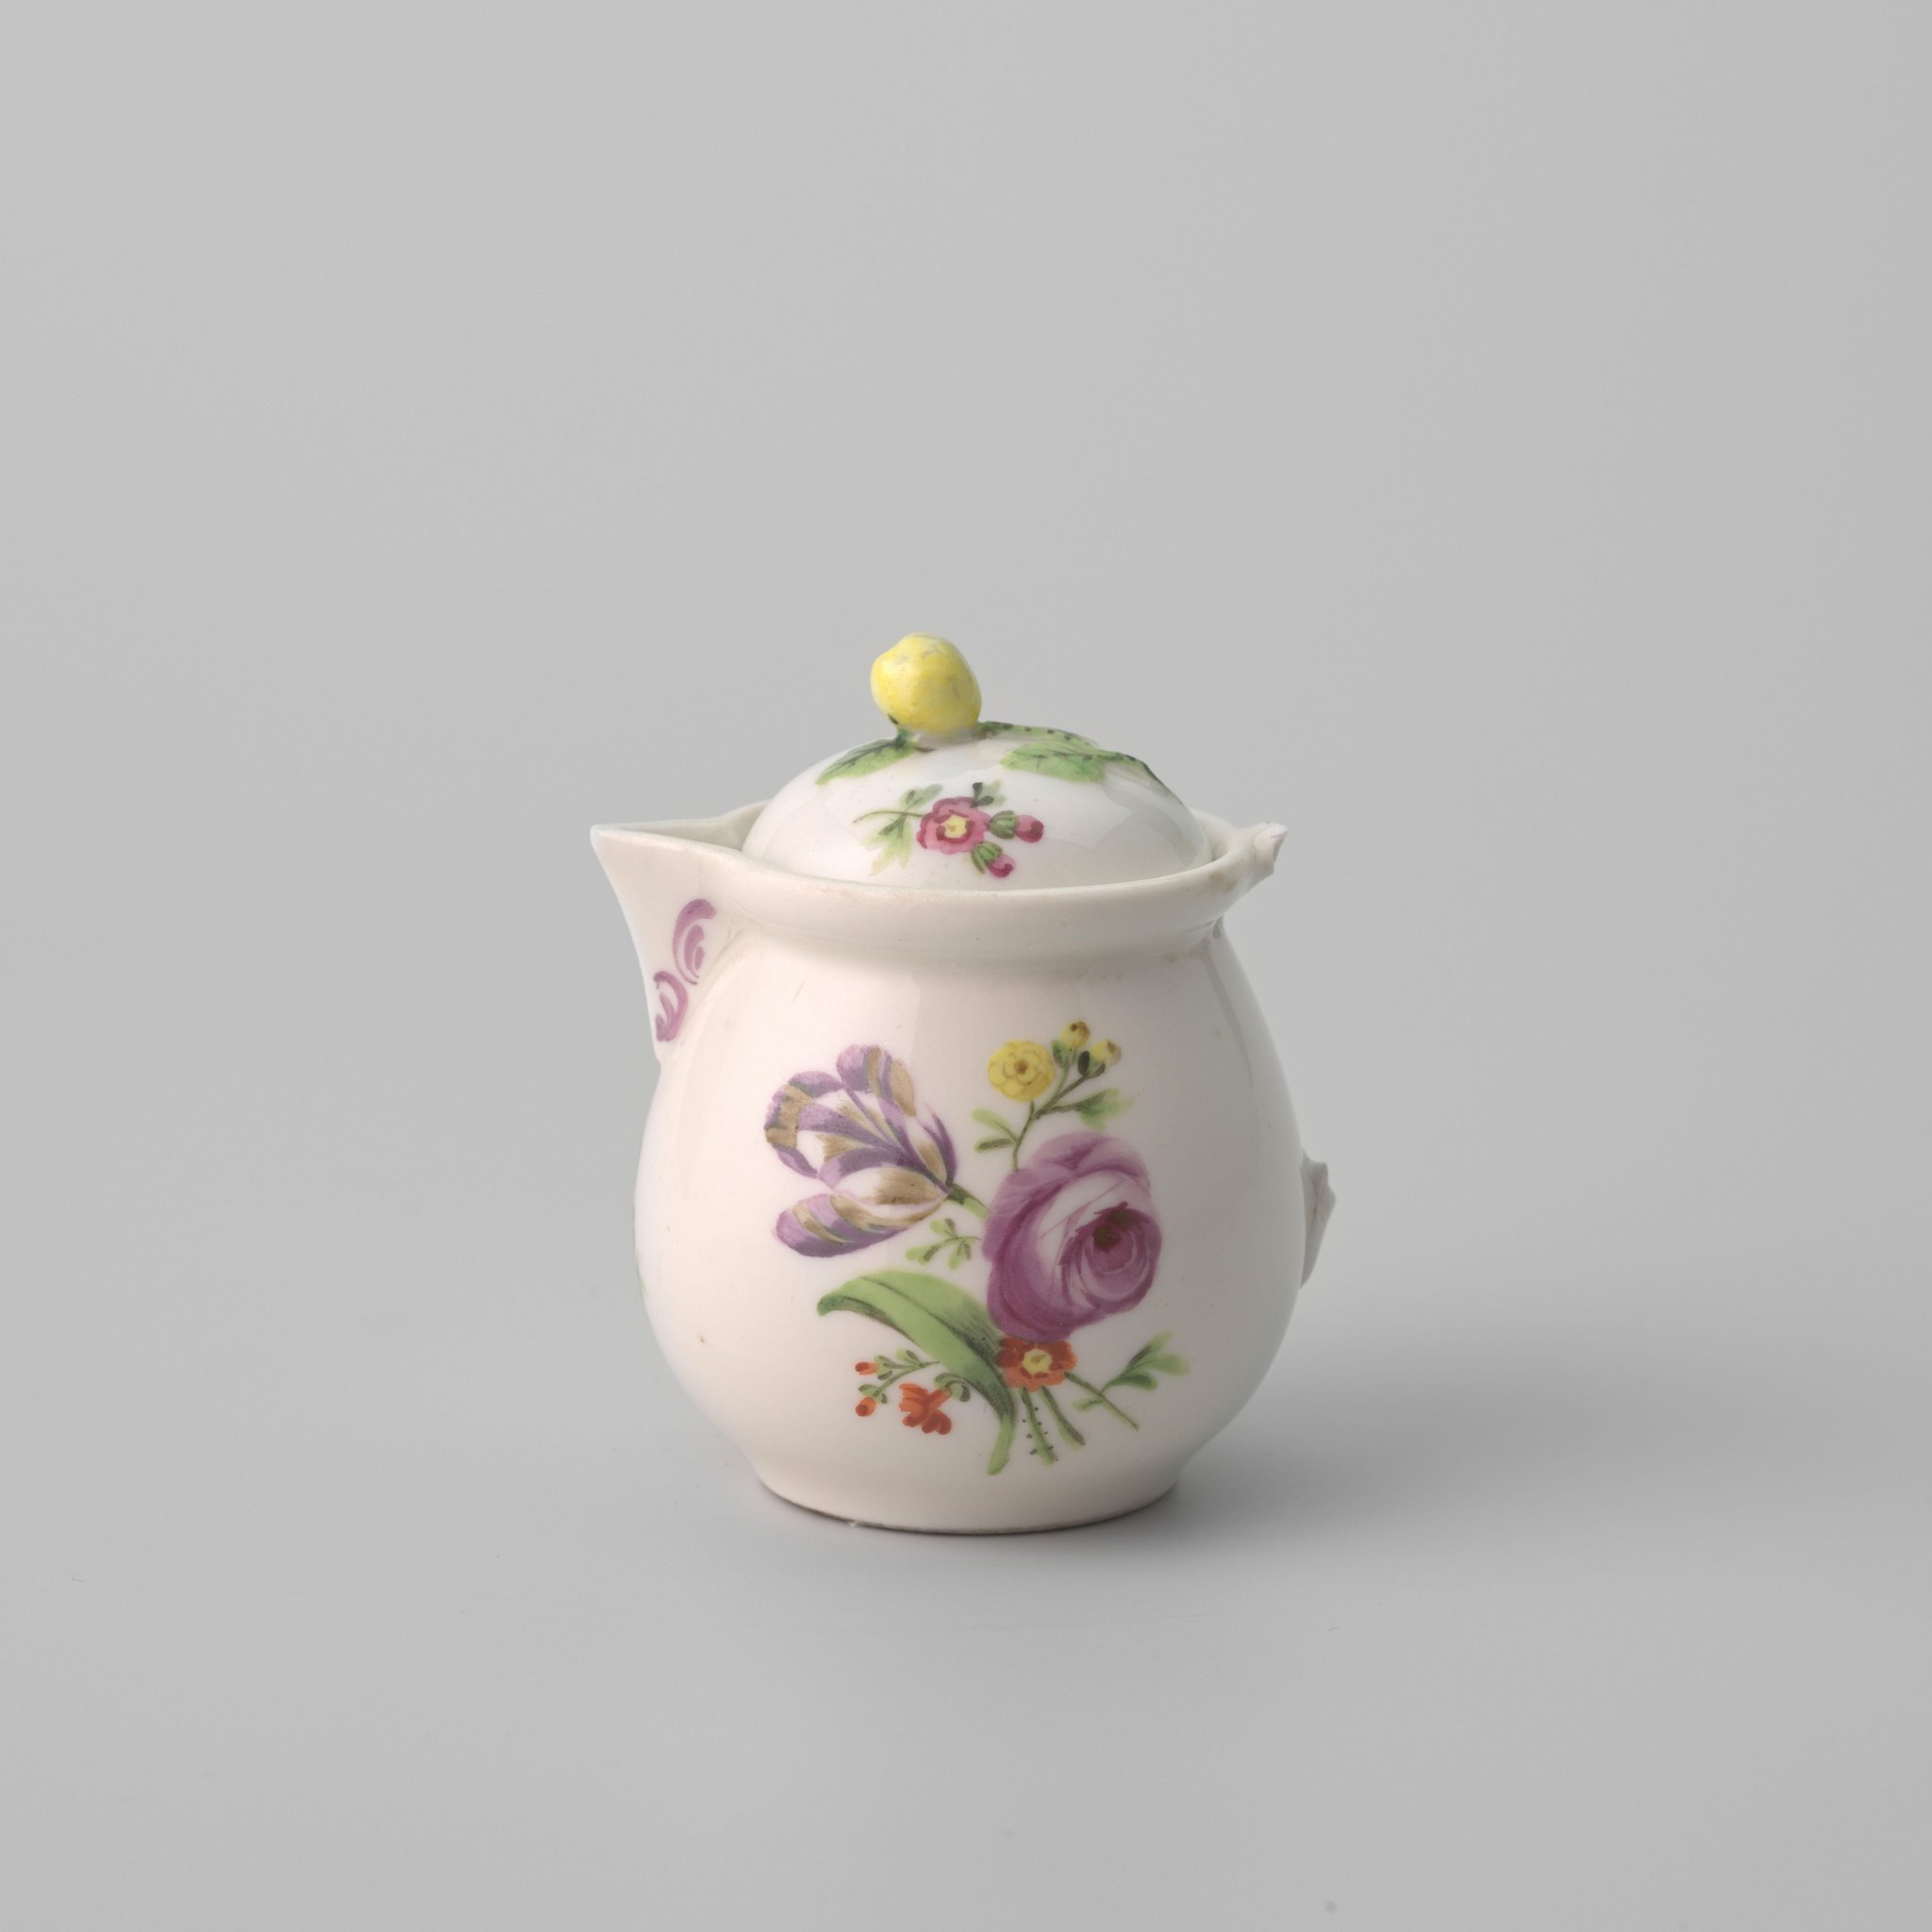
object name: service set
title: Milk jug with a bouquet and flower sprays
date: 1800-1849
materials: glaze, paint, porcelain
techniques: firing, forming, turning, vitrification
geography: vienna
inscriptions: mark: ‘schild/ N/ 90./ 4 / 87’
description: Melkkan van porselein met een bolvormige buik en korte tuit vanuit de nek en rand, beschilderd op het glazuur in rood, roze, groen, geel en paars. Op de buik tweemaal een boeket van verschillende bloemen (o.a. pioenroos) omgeven door losse takjes. De tuit en het (afgebroken) oor met ranken en bloemen. Gemerkt op de onderzijde met het schild, letter N en de nummers 90., 4 en 87.